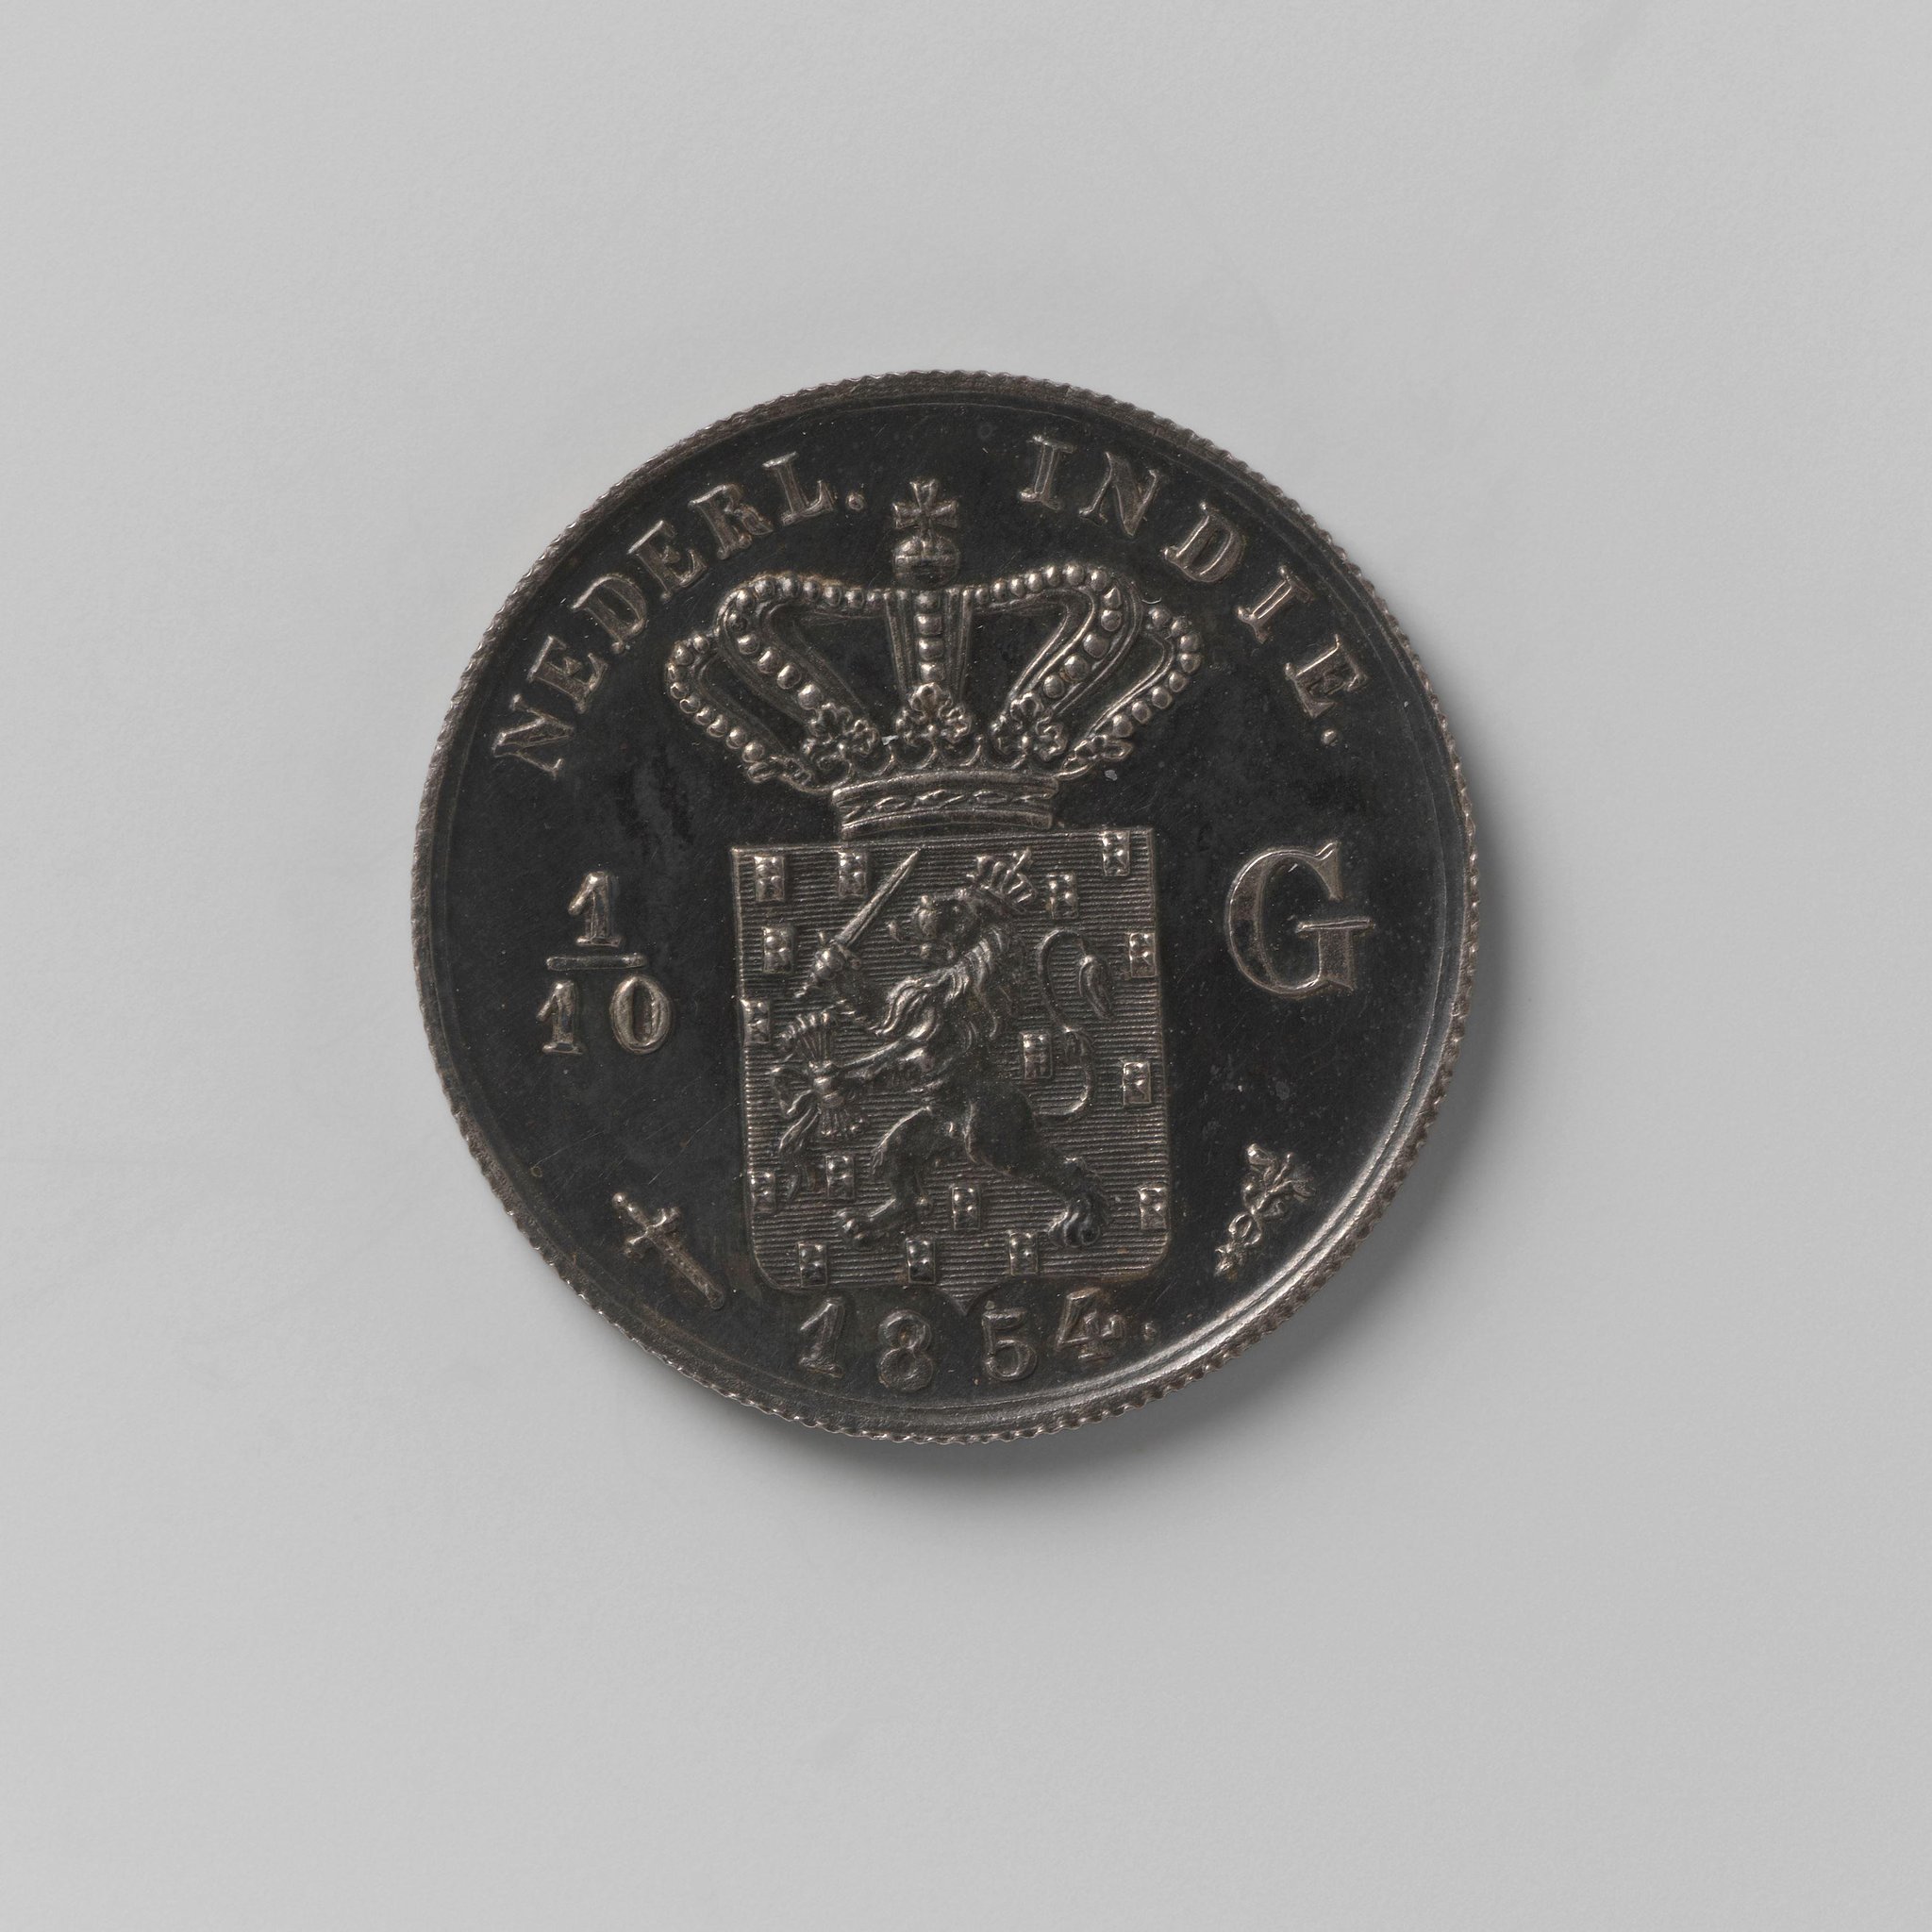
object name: tiende gulden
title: 1/10 gulden van Nederlands Indië, 1854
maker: willem iii (koning der nederlanden)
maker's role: koning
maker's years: 1817-1890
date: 1854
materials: silver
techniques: striking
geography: utrecht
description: Zilveren munt. Voorzijde: tussen waarde-aanduiding 1/10 G gekroond rijkswapenschild. Boven kroon landsaanduiding en onder wapenschild jaartal. Keerzijde: tweeregelig Maleis opschrift in Arabische tekens, waaromheen omschrift in het Javaans. Kartelrand.